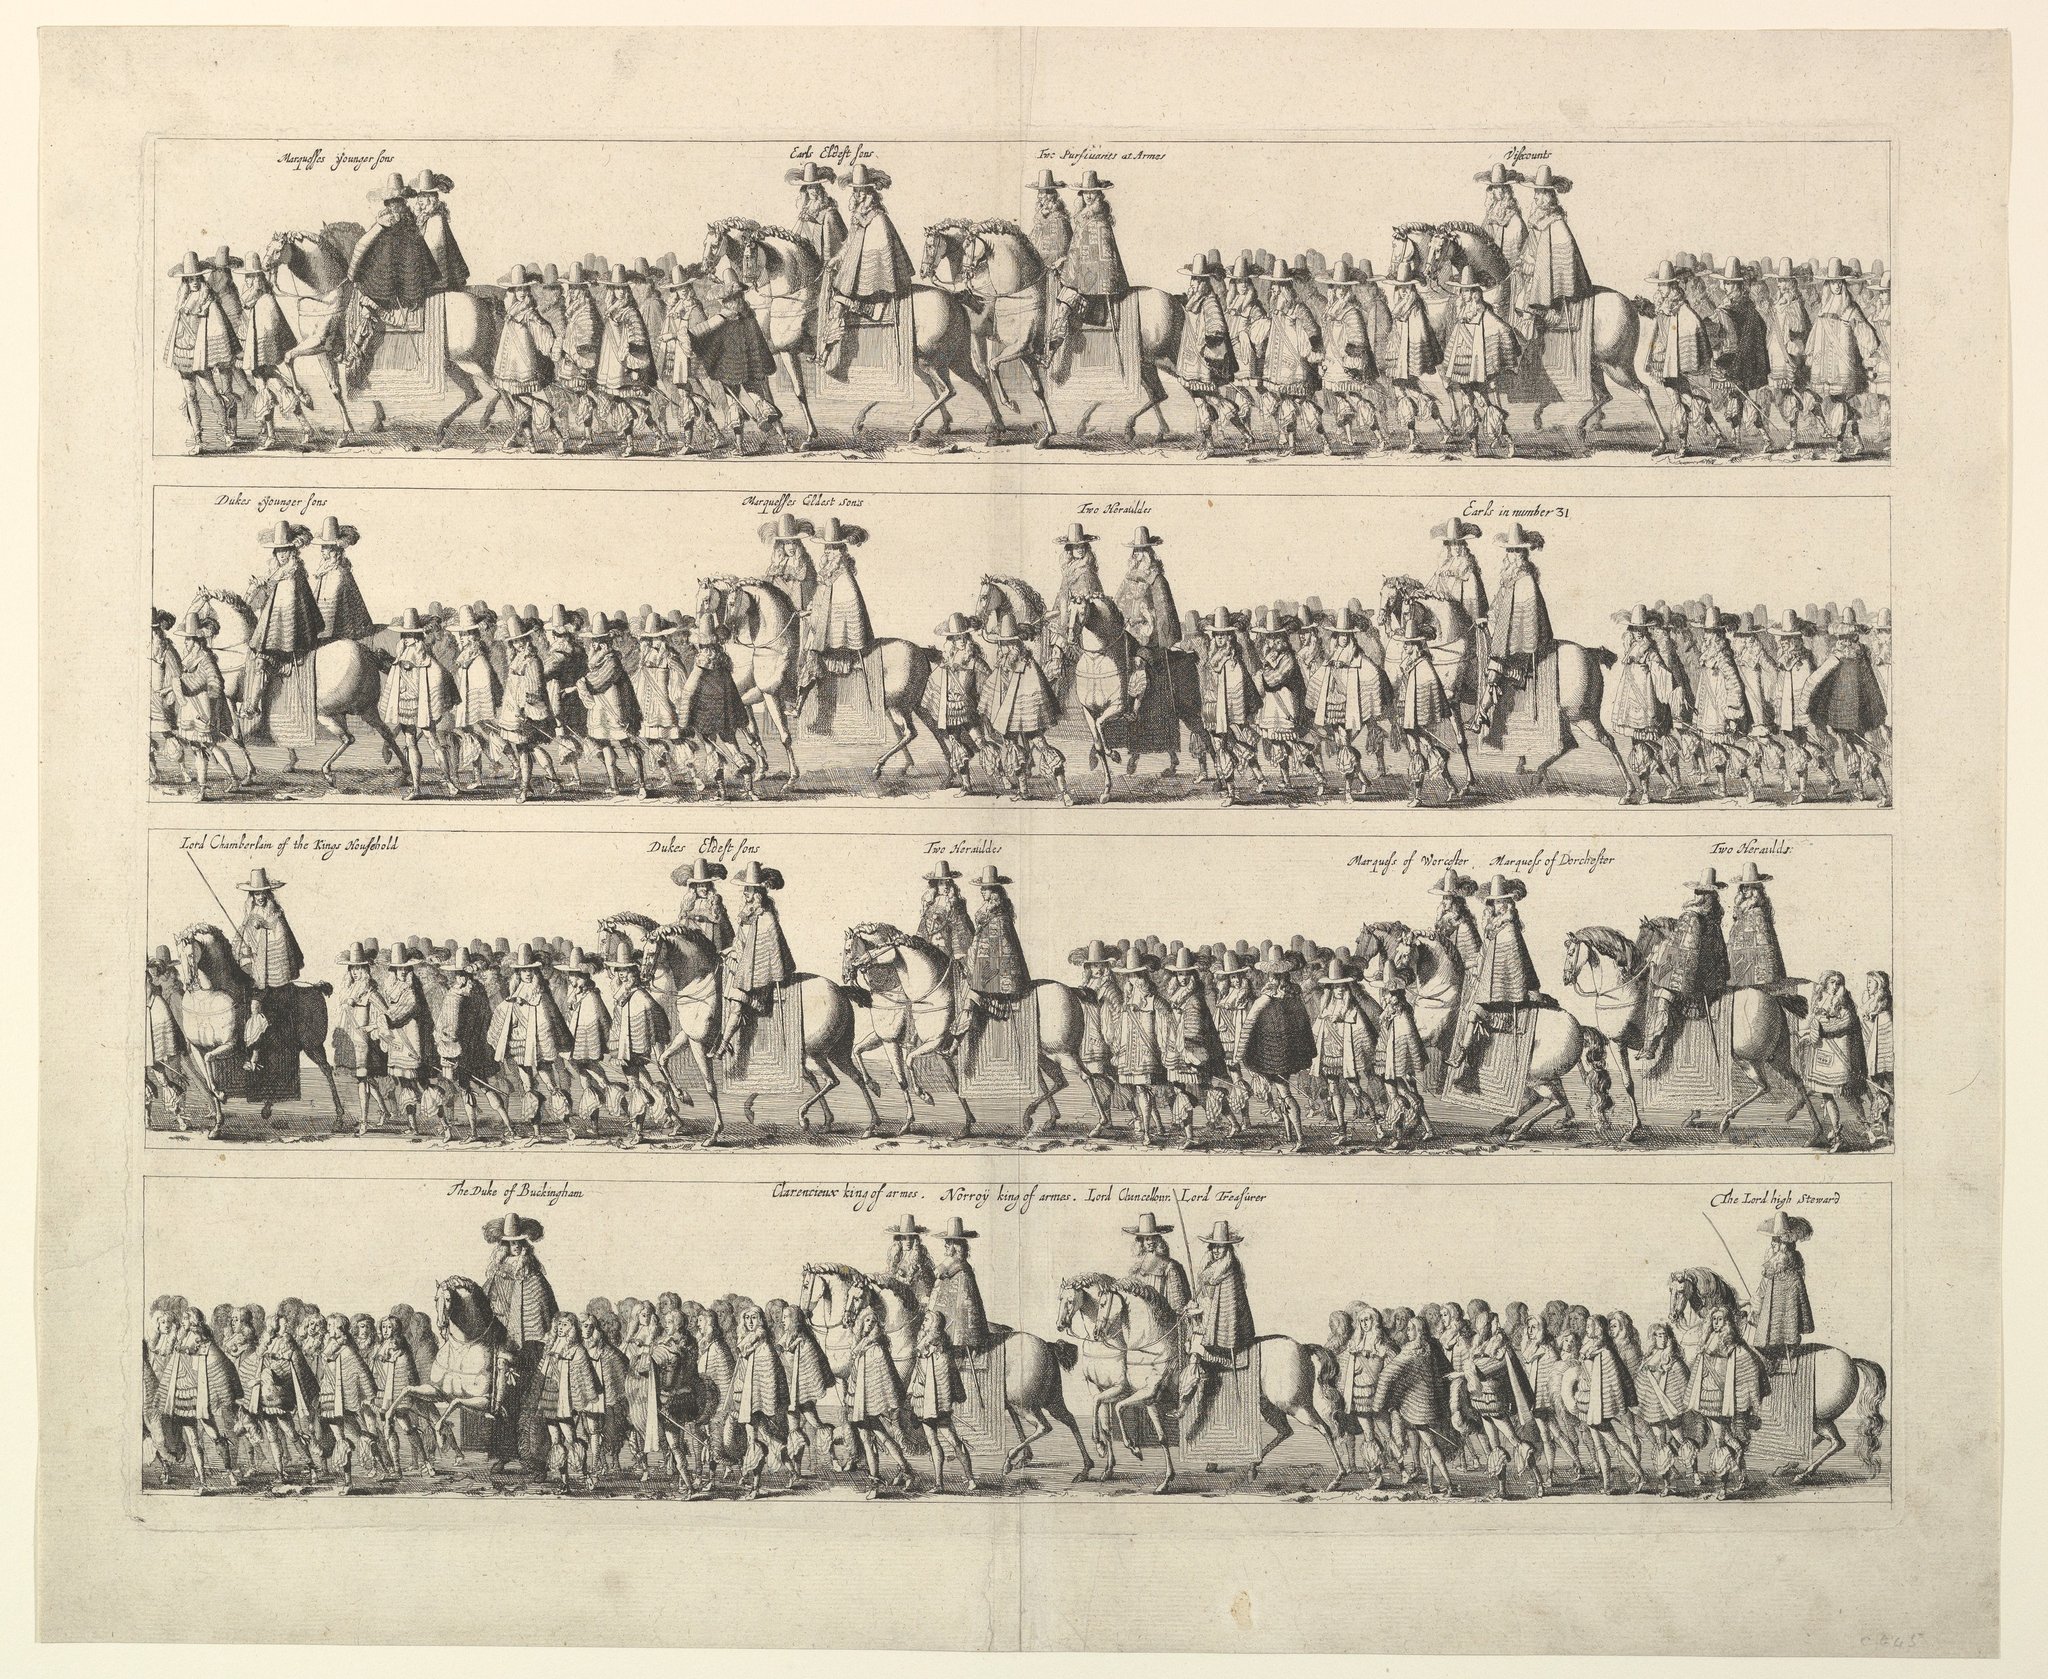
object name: print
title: Coronation Procession of Charles II Through London (from John Ogilby's "The Entertainment of...Charles II," London, 1662)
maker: wenceslaus hollar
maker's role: artist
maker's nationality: bohemian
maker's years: 1607-1677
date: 1662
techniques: etching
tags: soldiers,weapons,horses